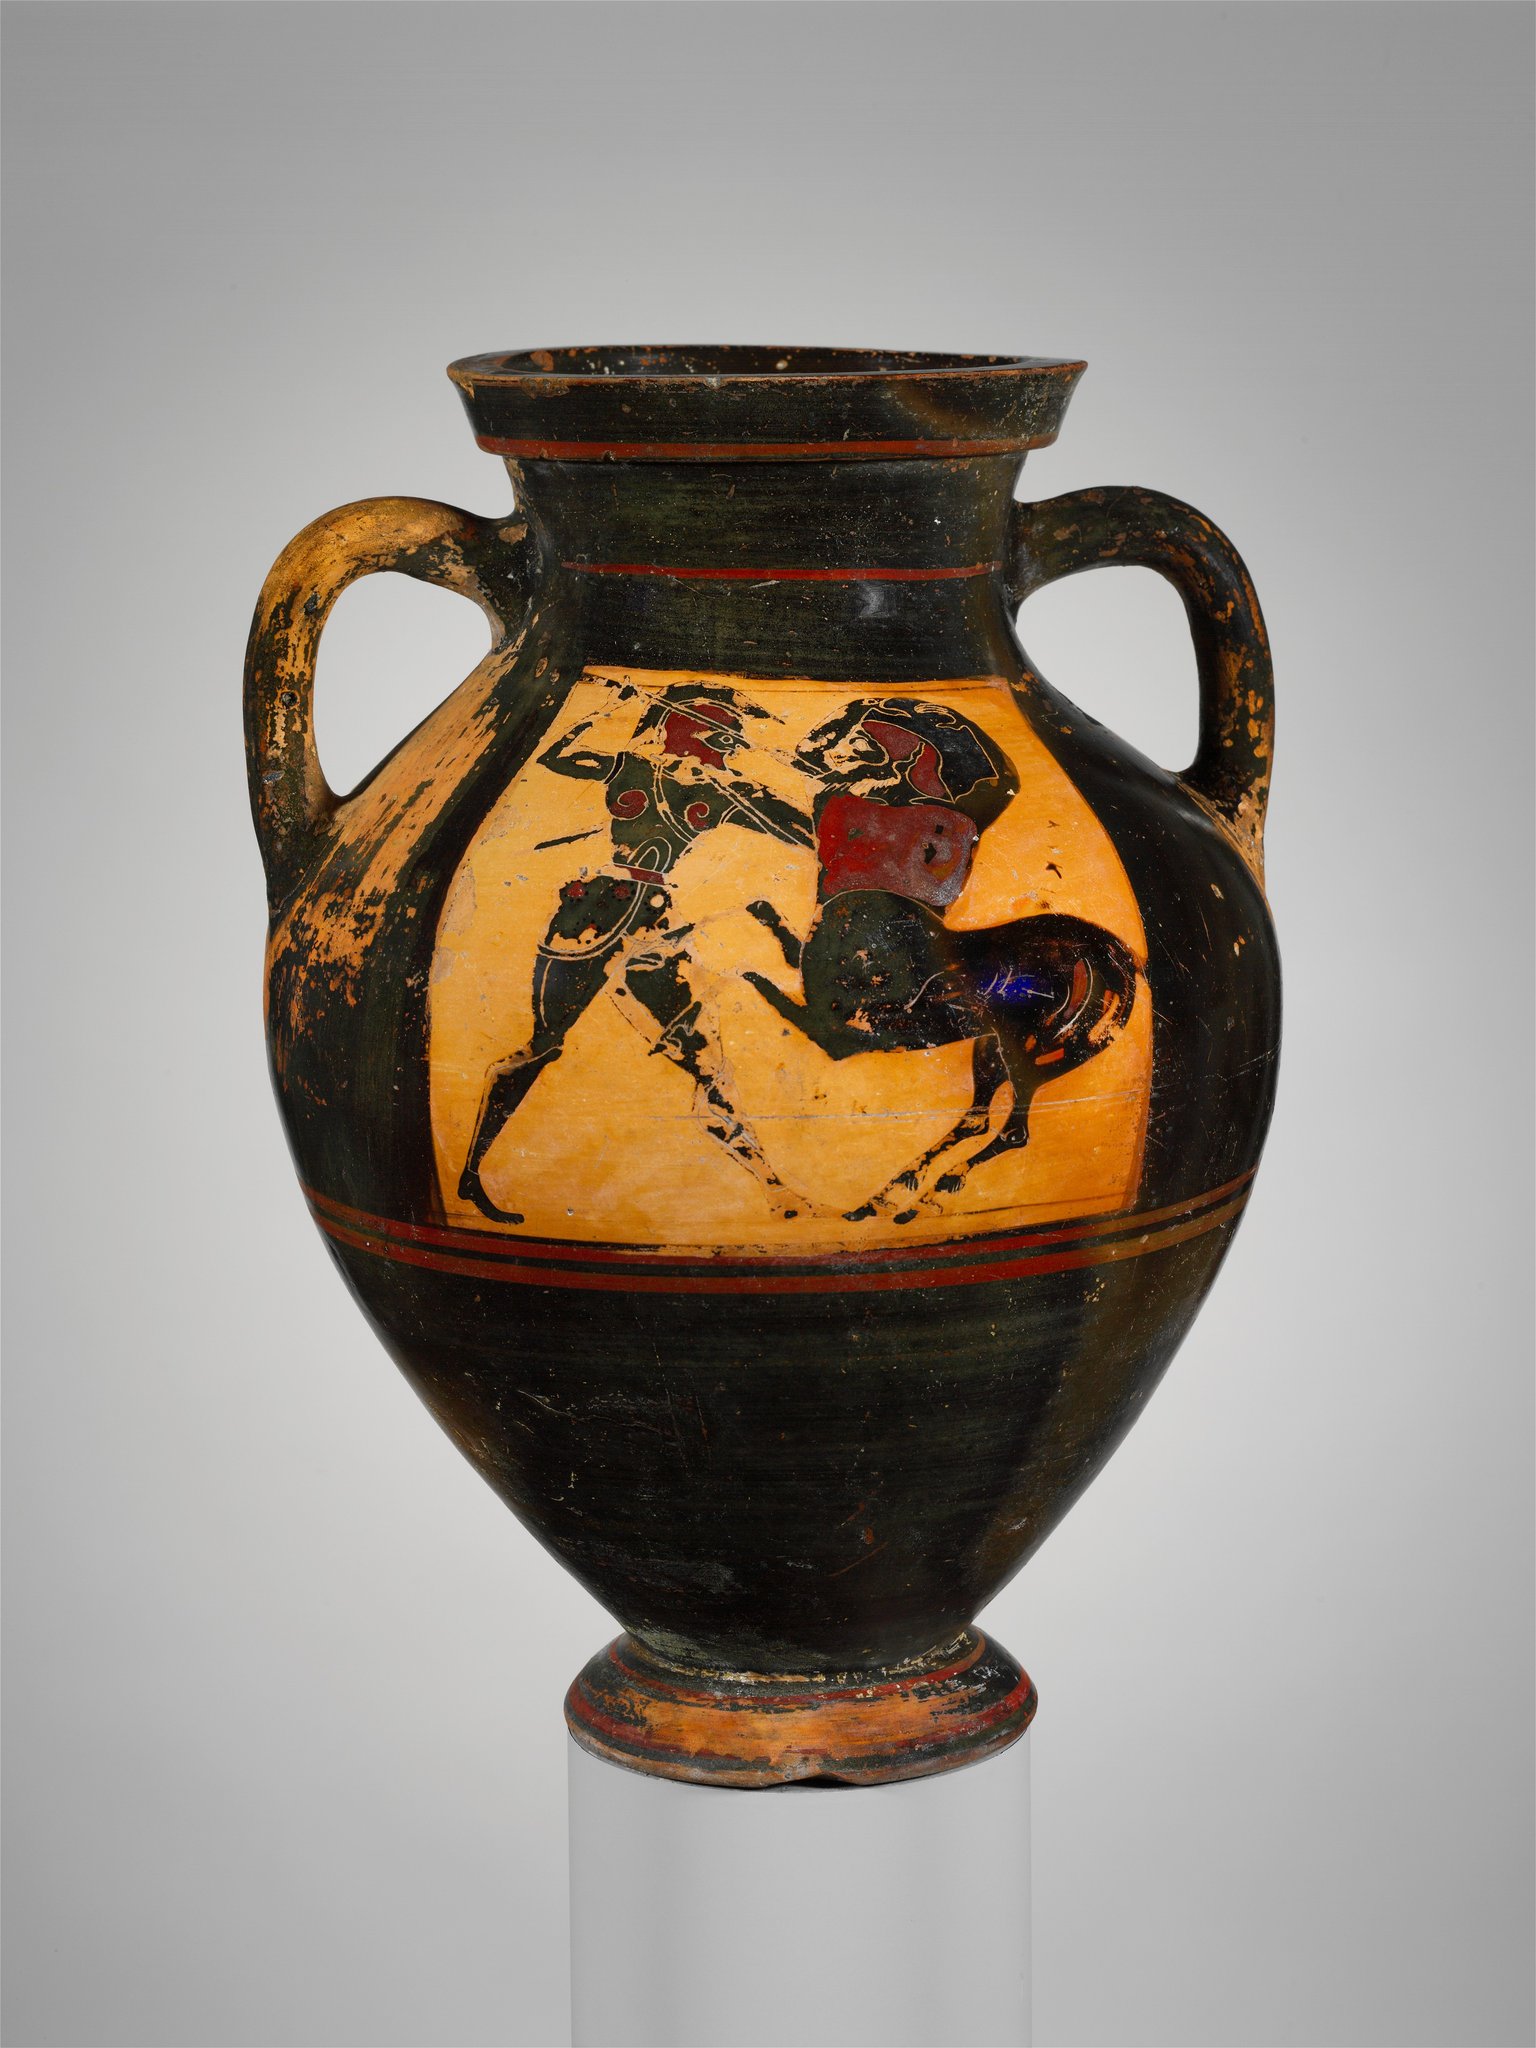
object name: amphora, type b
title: Terracotta amphora (jar)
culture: greek, attic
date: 560-550 BCE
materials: terracotta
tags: centaurs,herakles